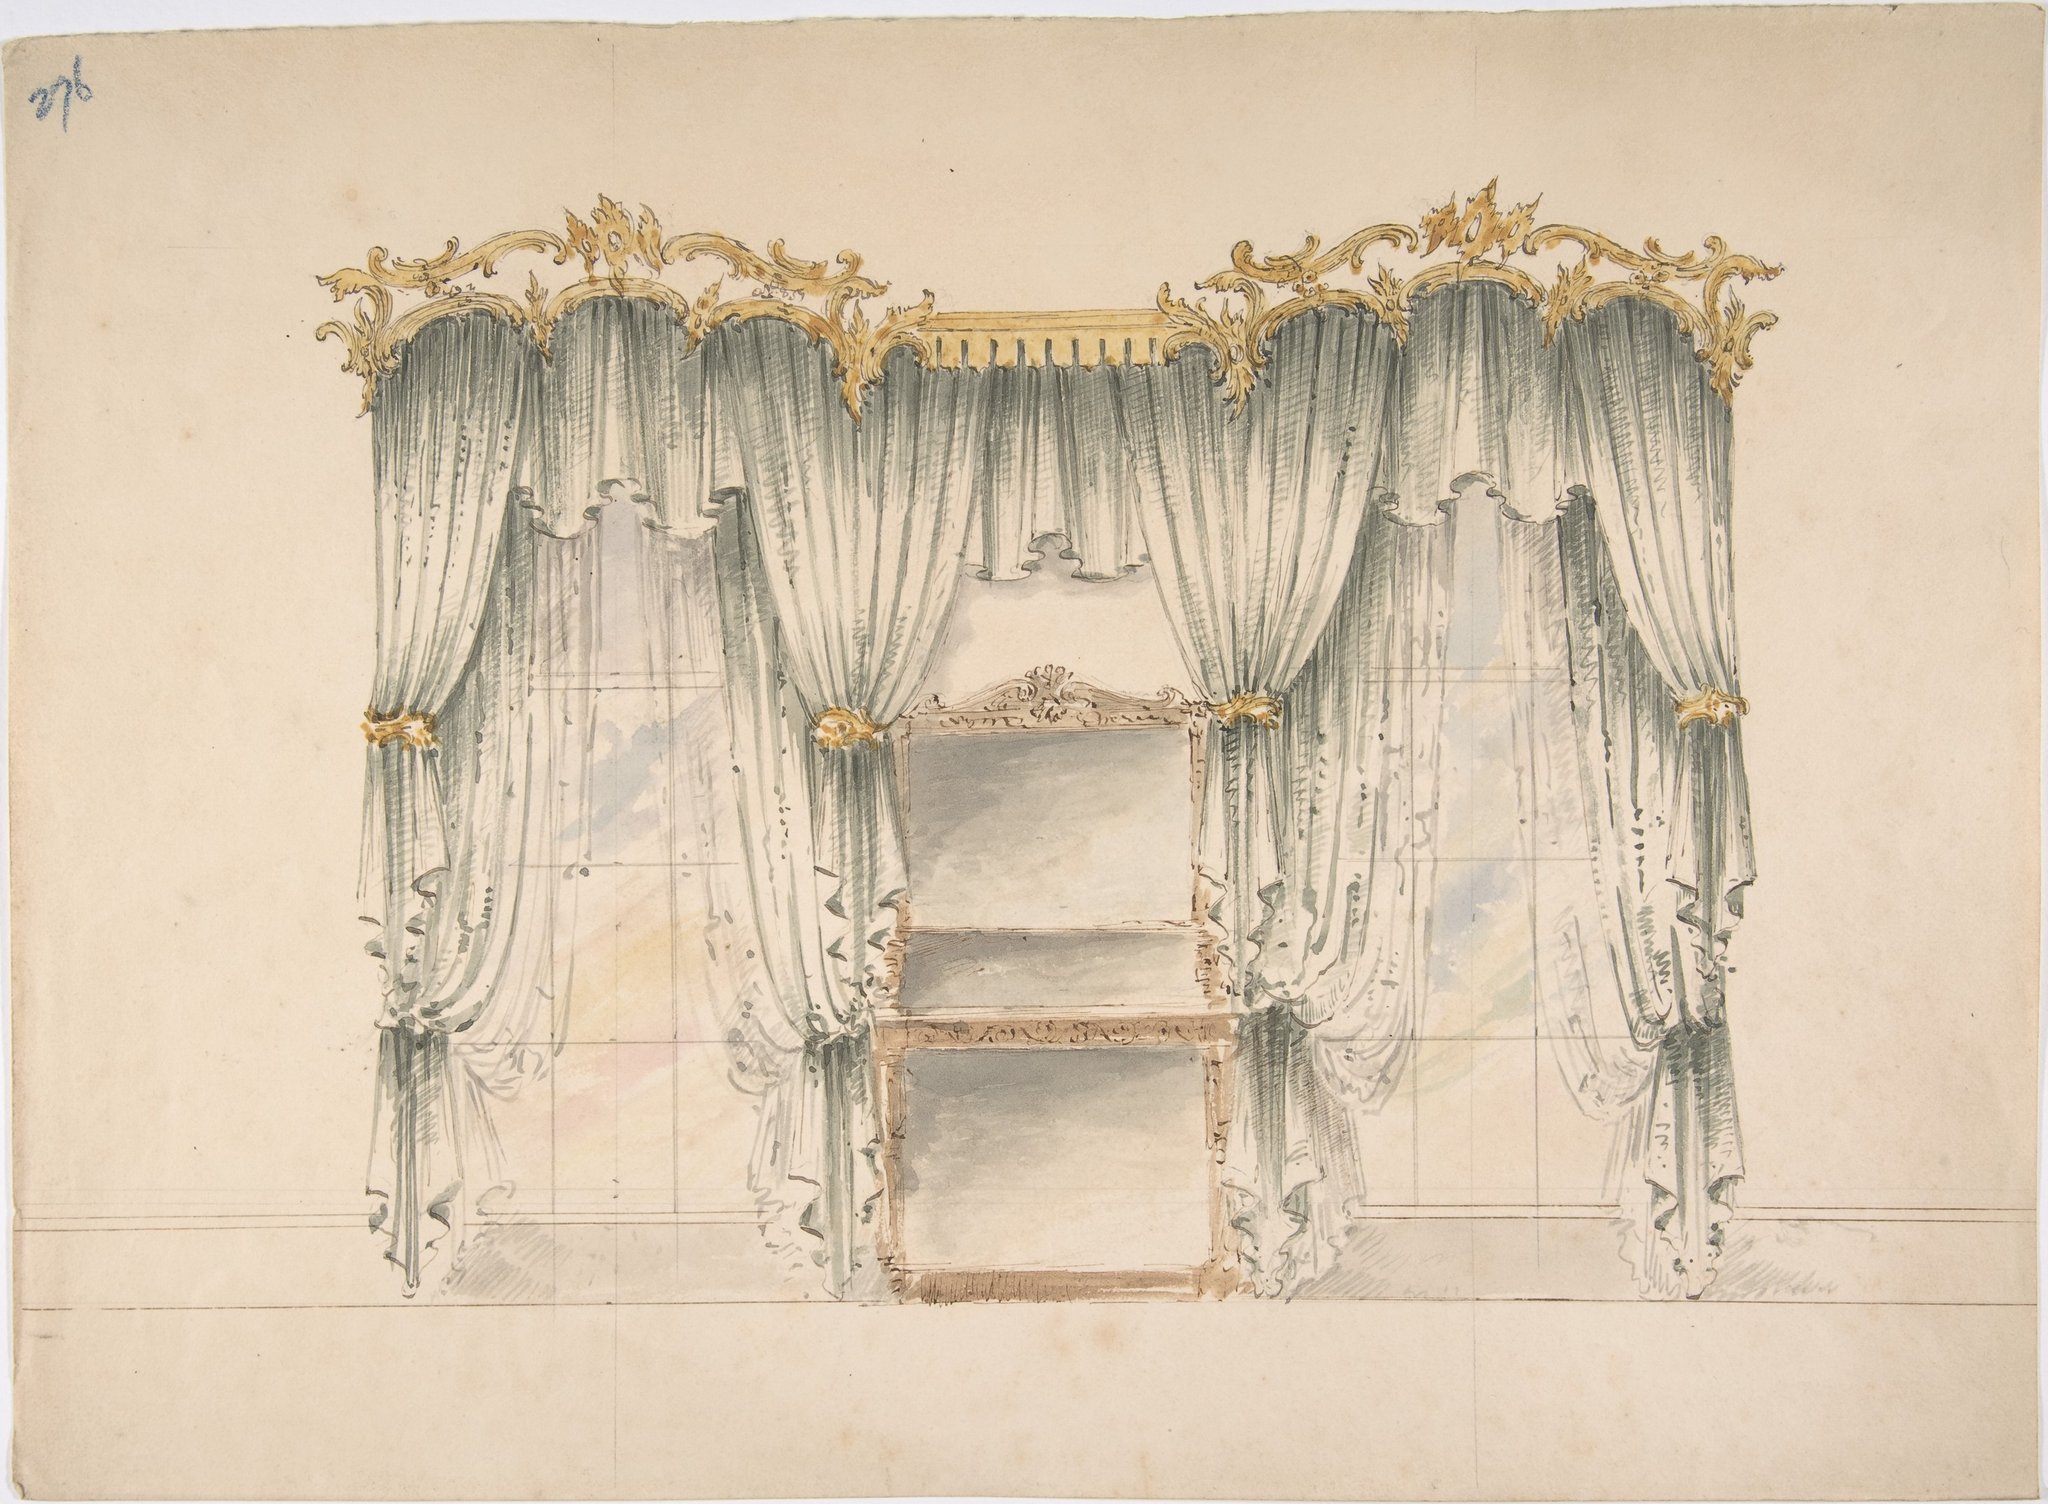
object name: drawing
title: Design for White Curtains with Gold Pendiment and Tie-backs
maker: anonymous, british, 19th century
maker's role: artist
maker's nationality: british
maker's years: 1800-1900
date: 1801-1833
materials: ink, watercolor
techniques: brush, pen, wash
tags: curtains